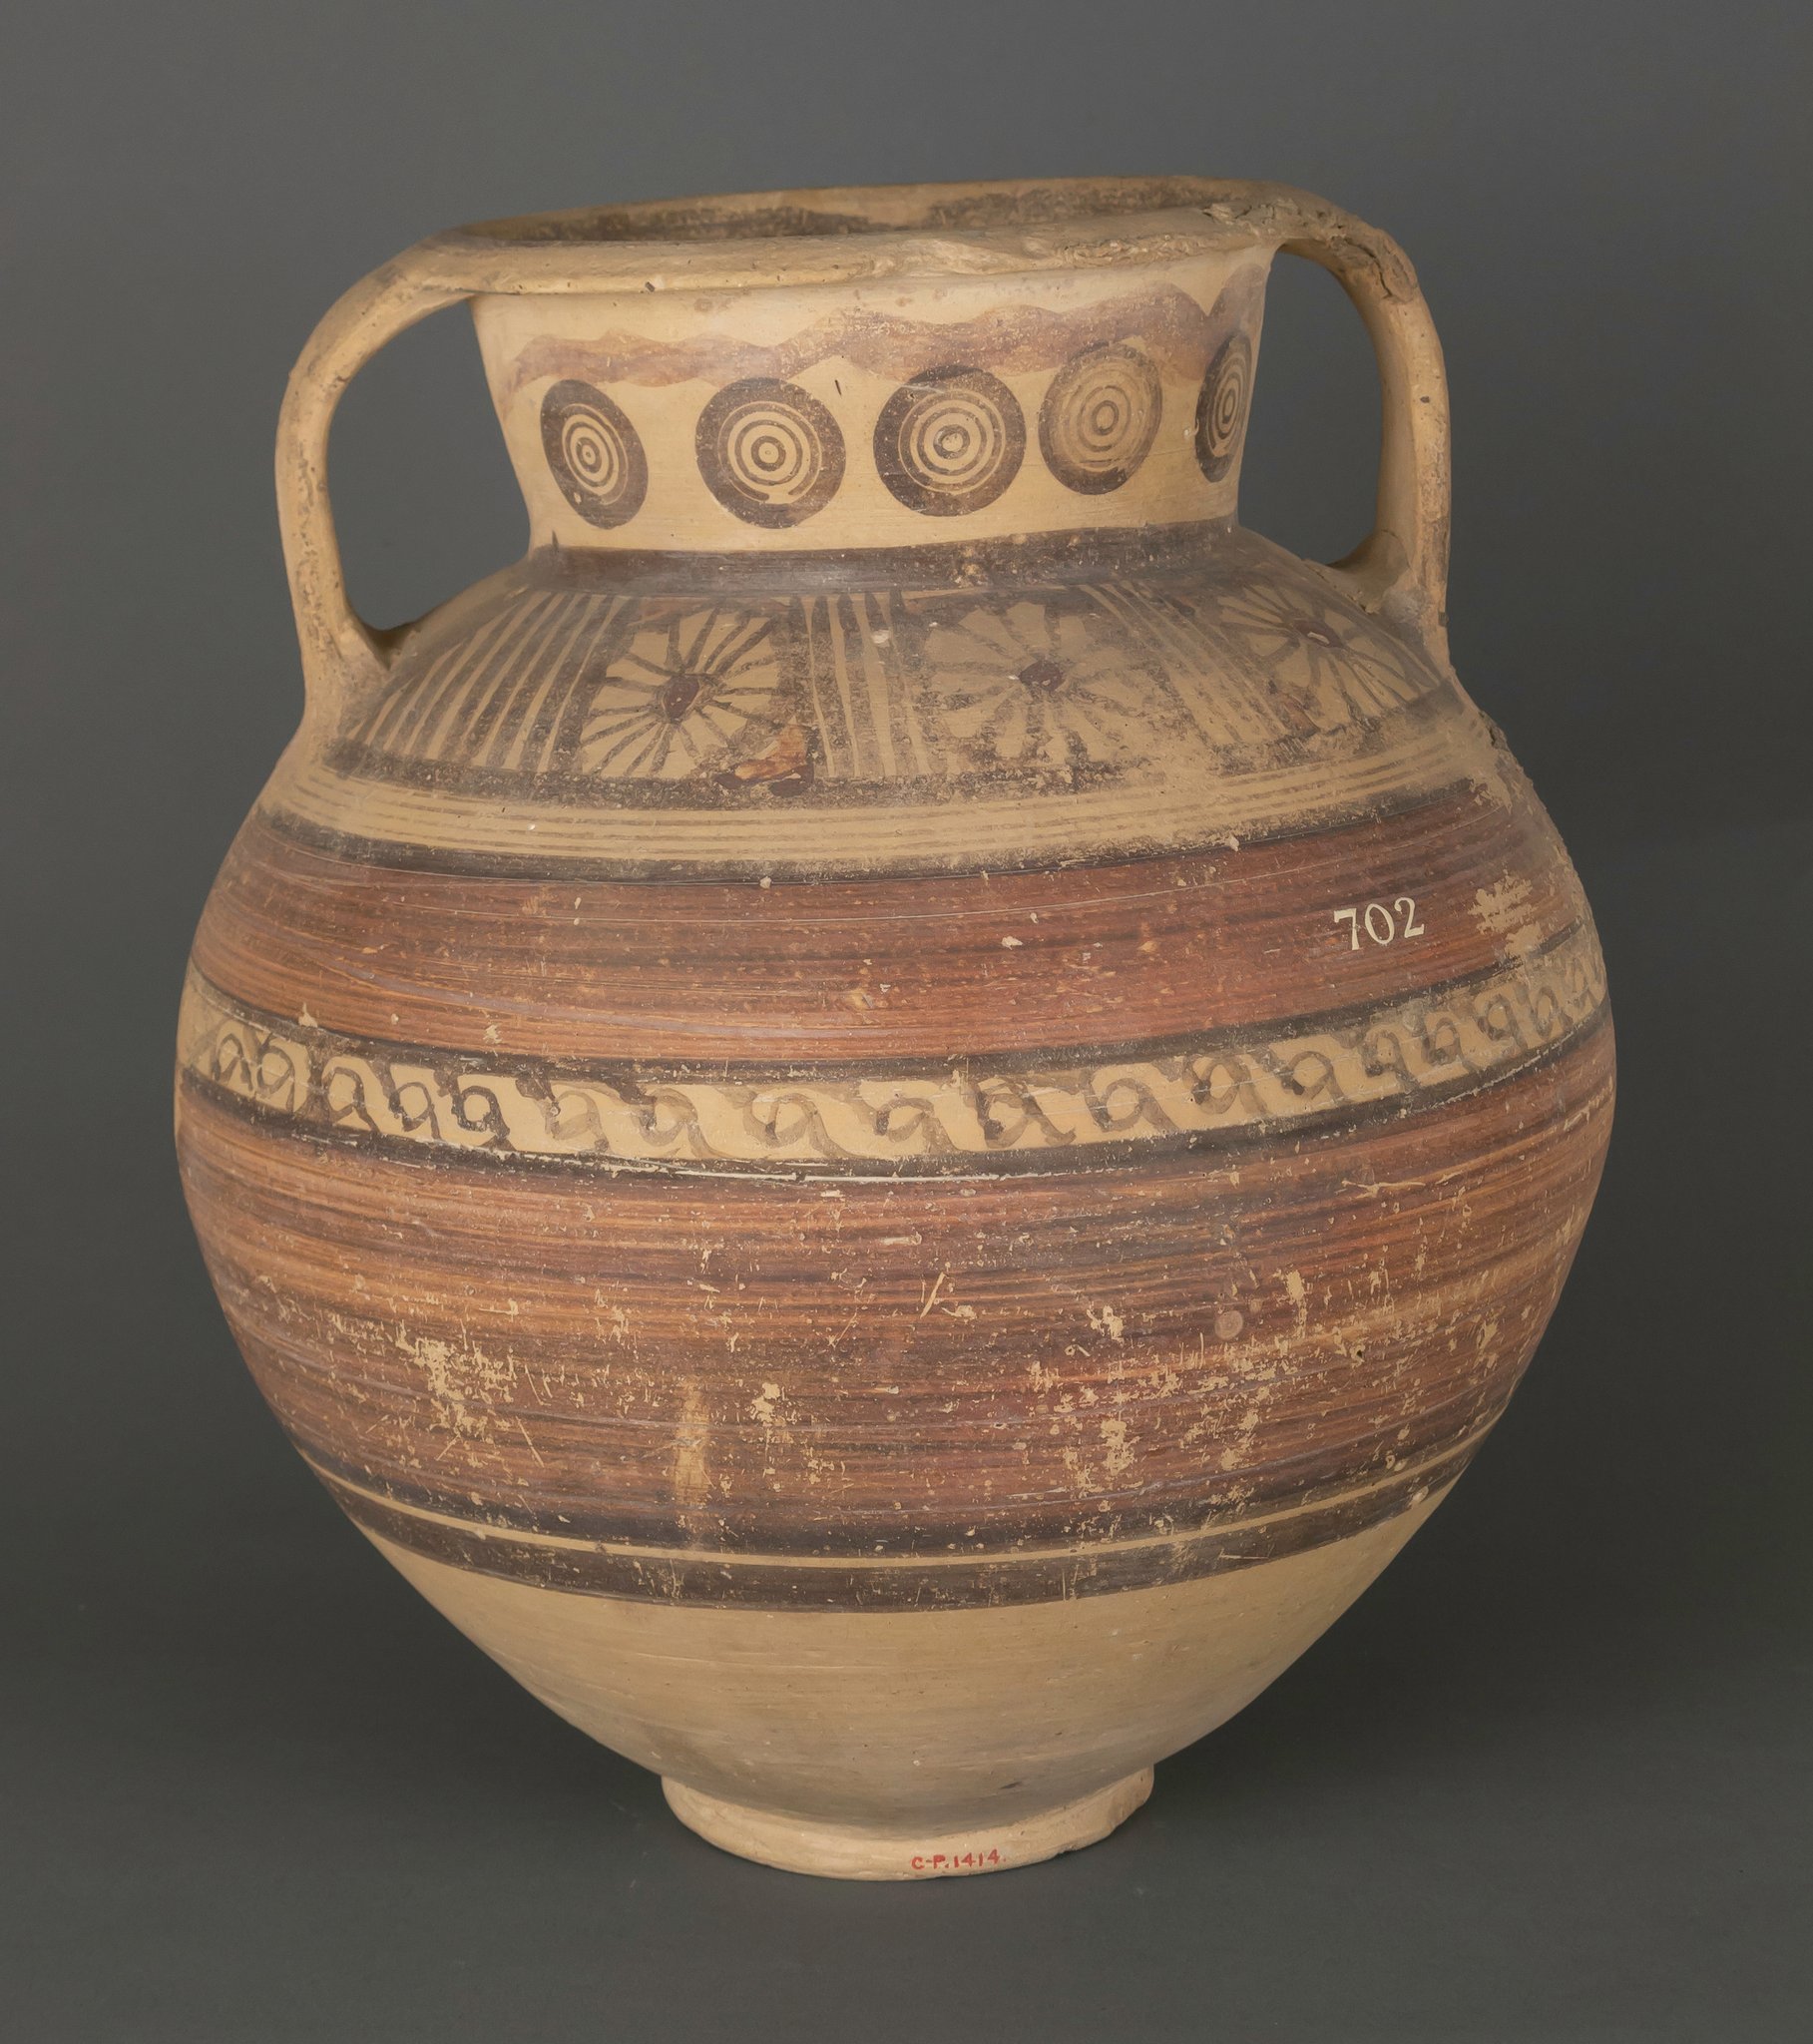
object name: amphora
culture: cypriot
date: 600-480 BCE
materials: terracotta